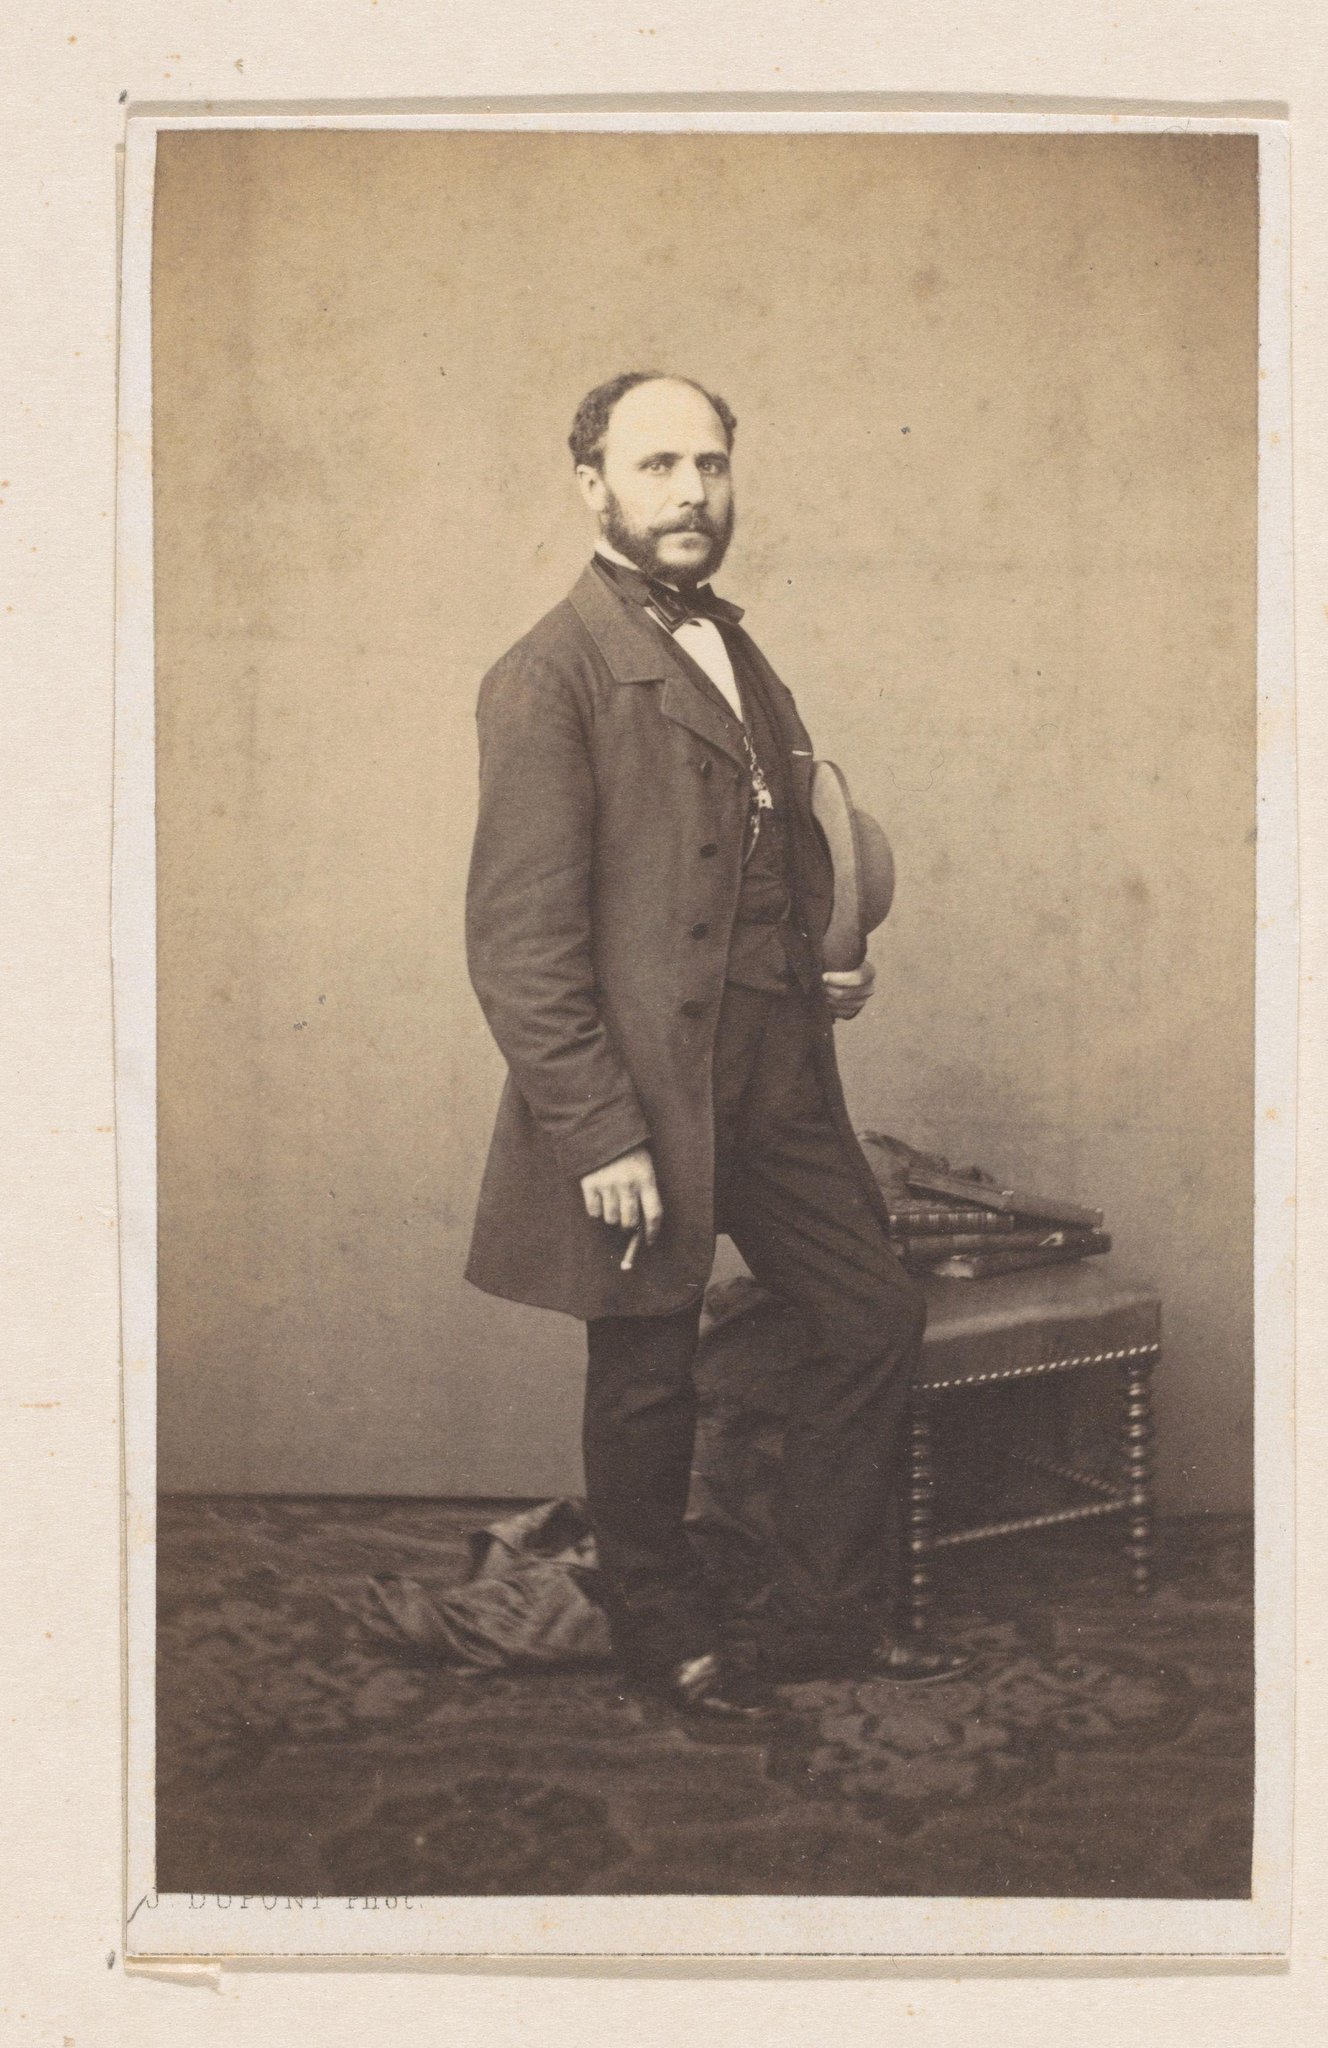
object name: photograph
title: Portret van de schilder Lodewijk Jan de Taeye, ten voeten uit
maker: joseph dupont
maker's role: fotograaf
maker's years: 1818-1901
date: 1861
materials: cardboard, paper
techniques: albumen print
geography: antwerp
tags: ghent, antwerp, painter, historical persons, portrait, self-portrait of painter, portrait, self-portrait of artist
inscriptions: inscription: ‘ETABLISSEMENT PHOTOGRAPHIQUE/ de/ J. DUPONT/ Place de Meir 32/ ANVERS/ Maison fondée en 1853’